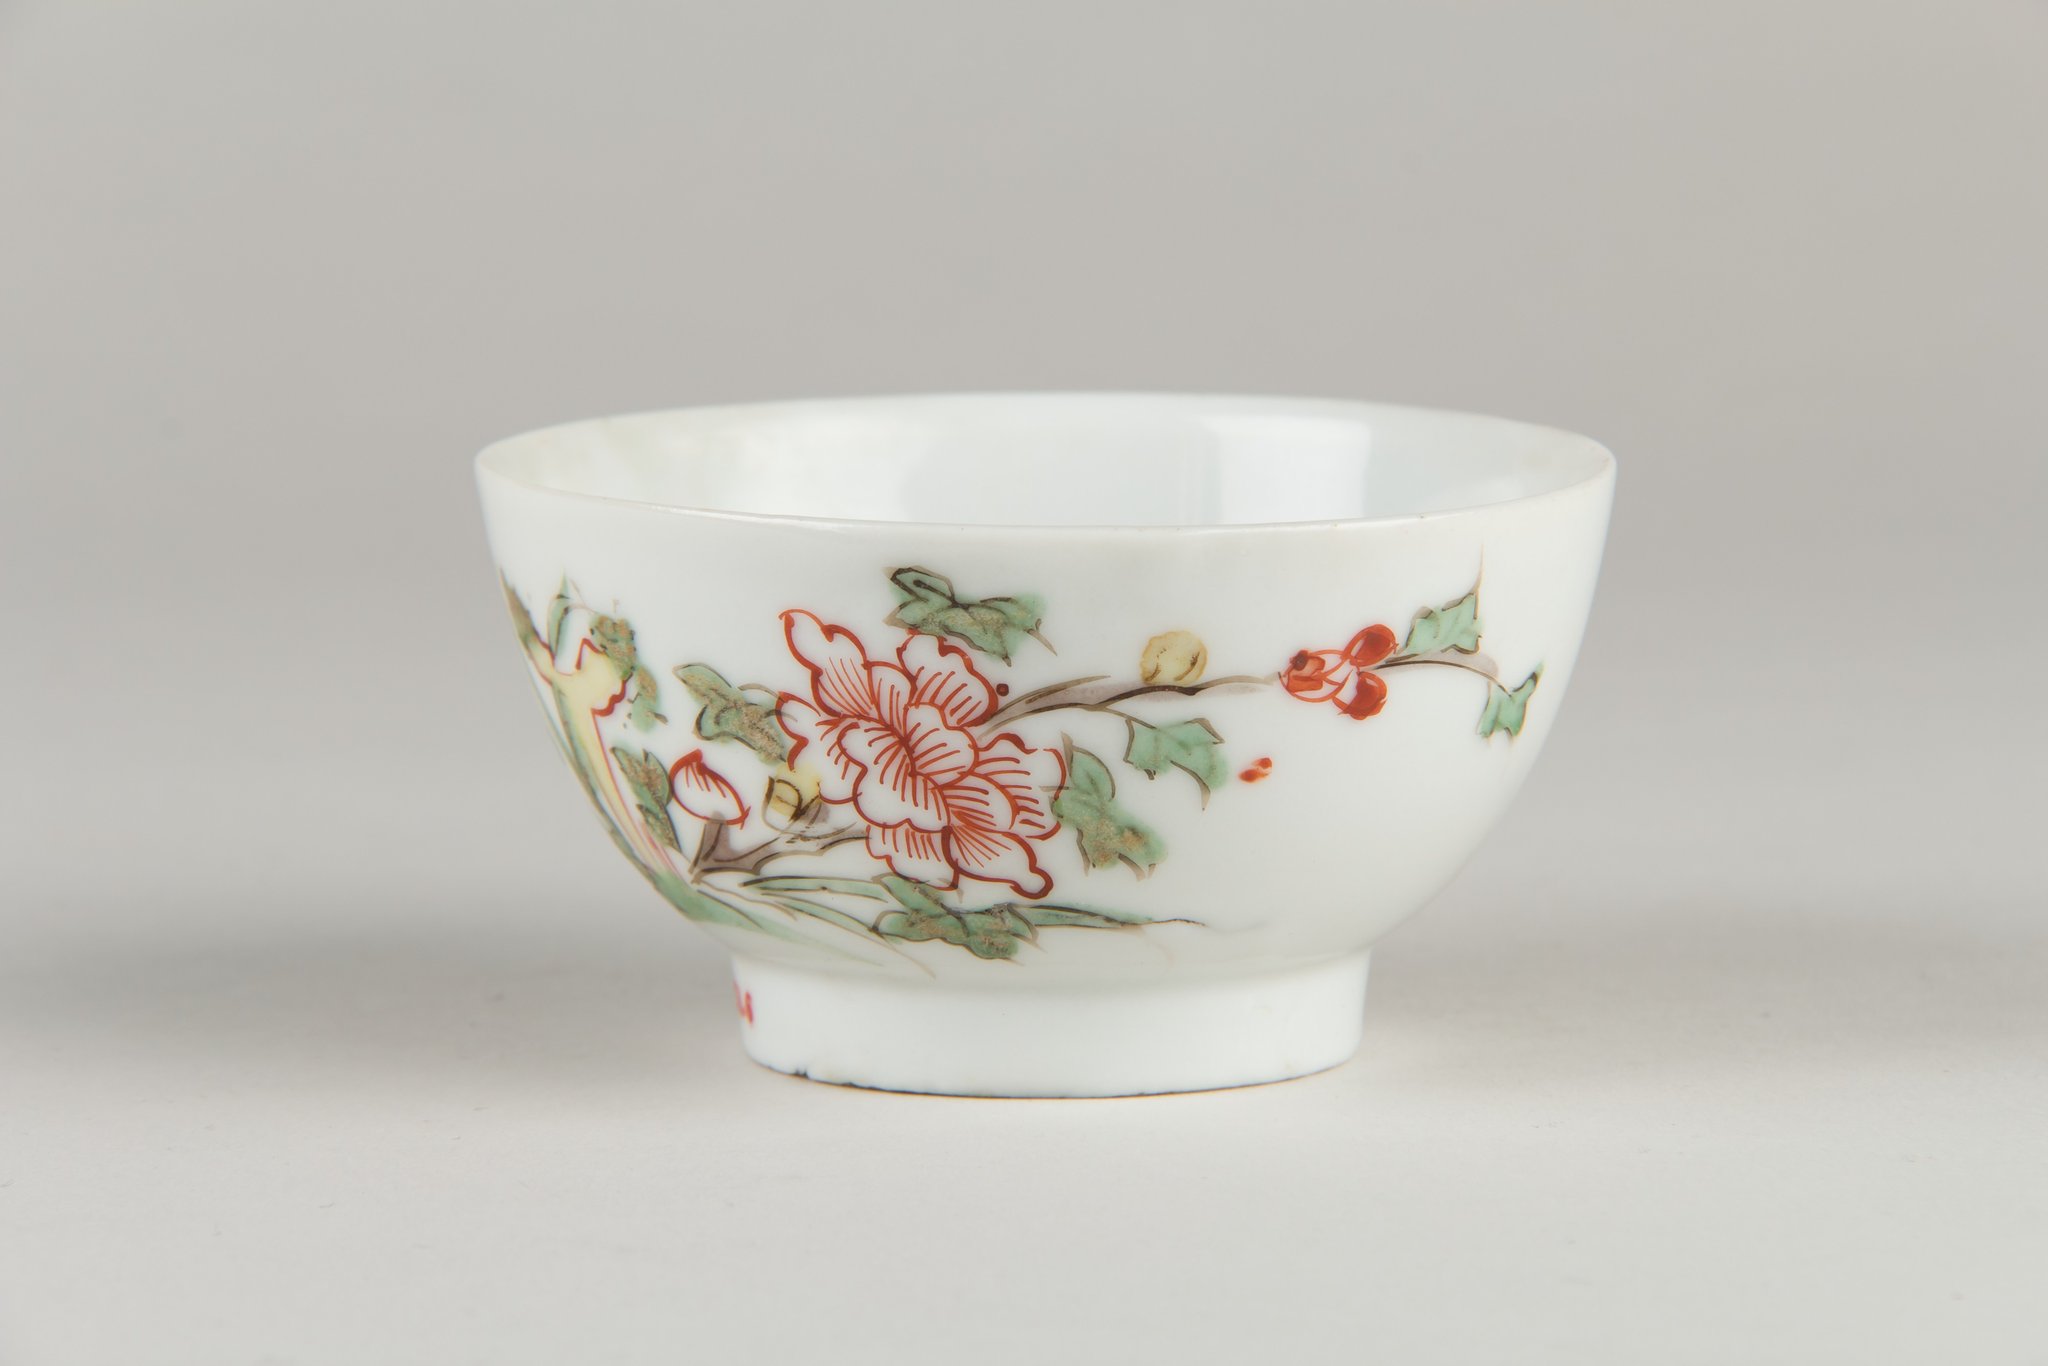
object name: cup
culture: chinese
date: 1465-1487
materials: porcelain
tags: flowers,leaves